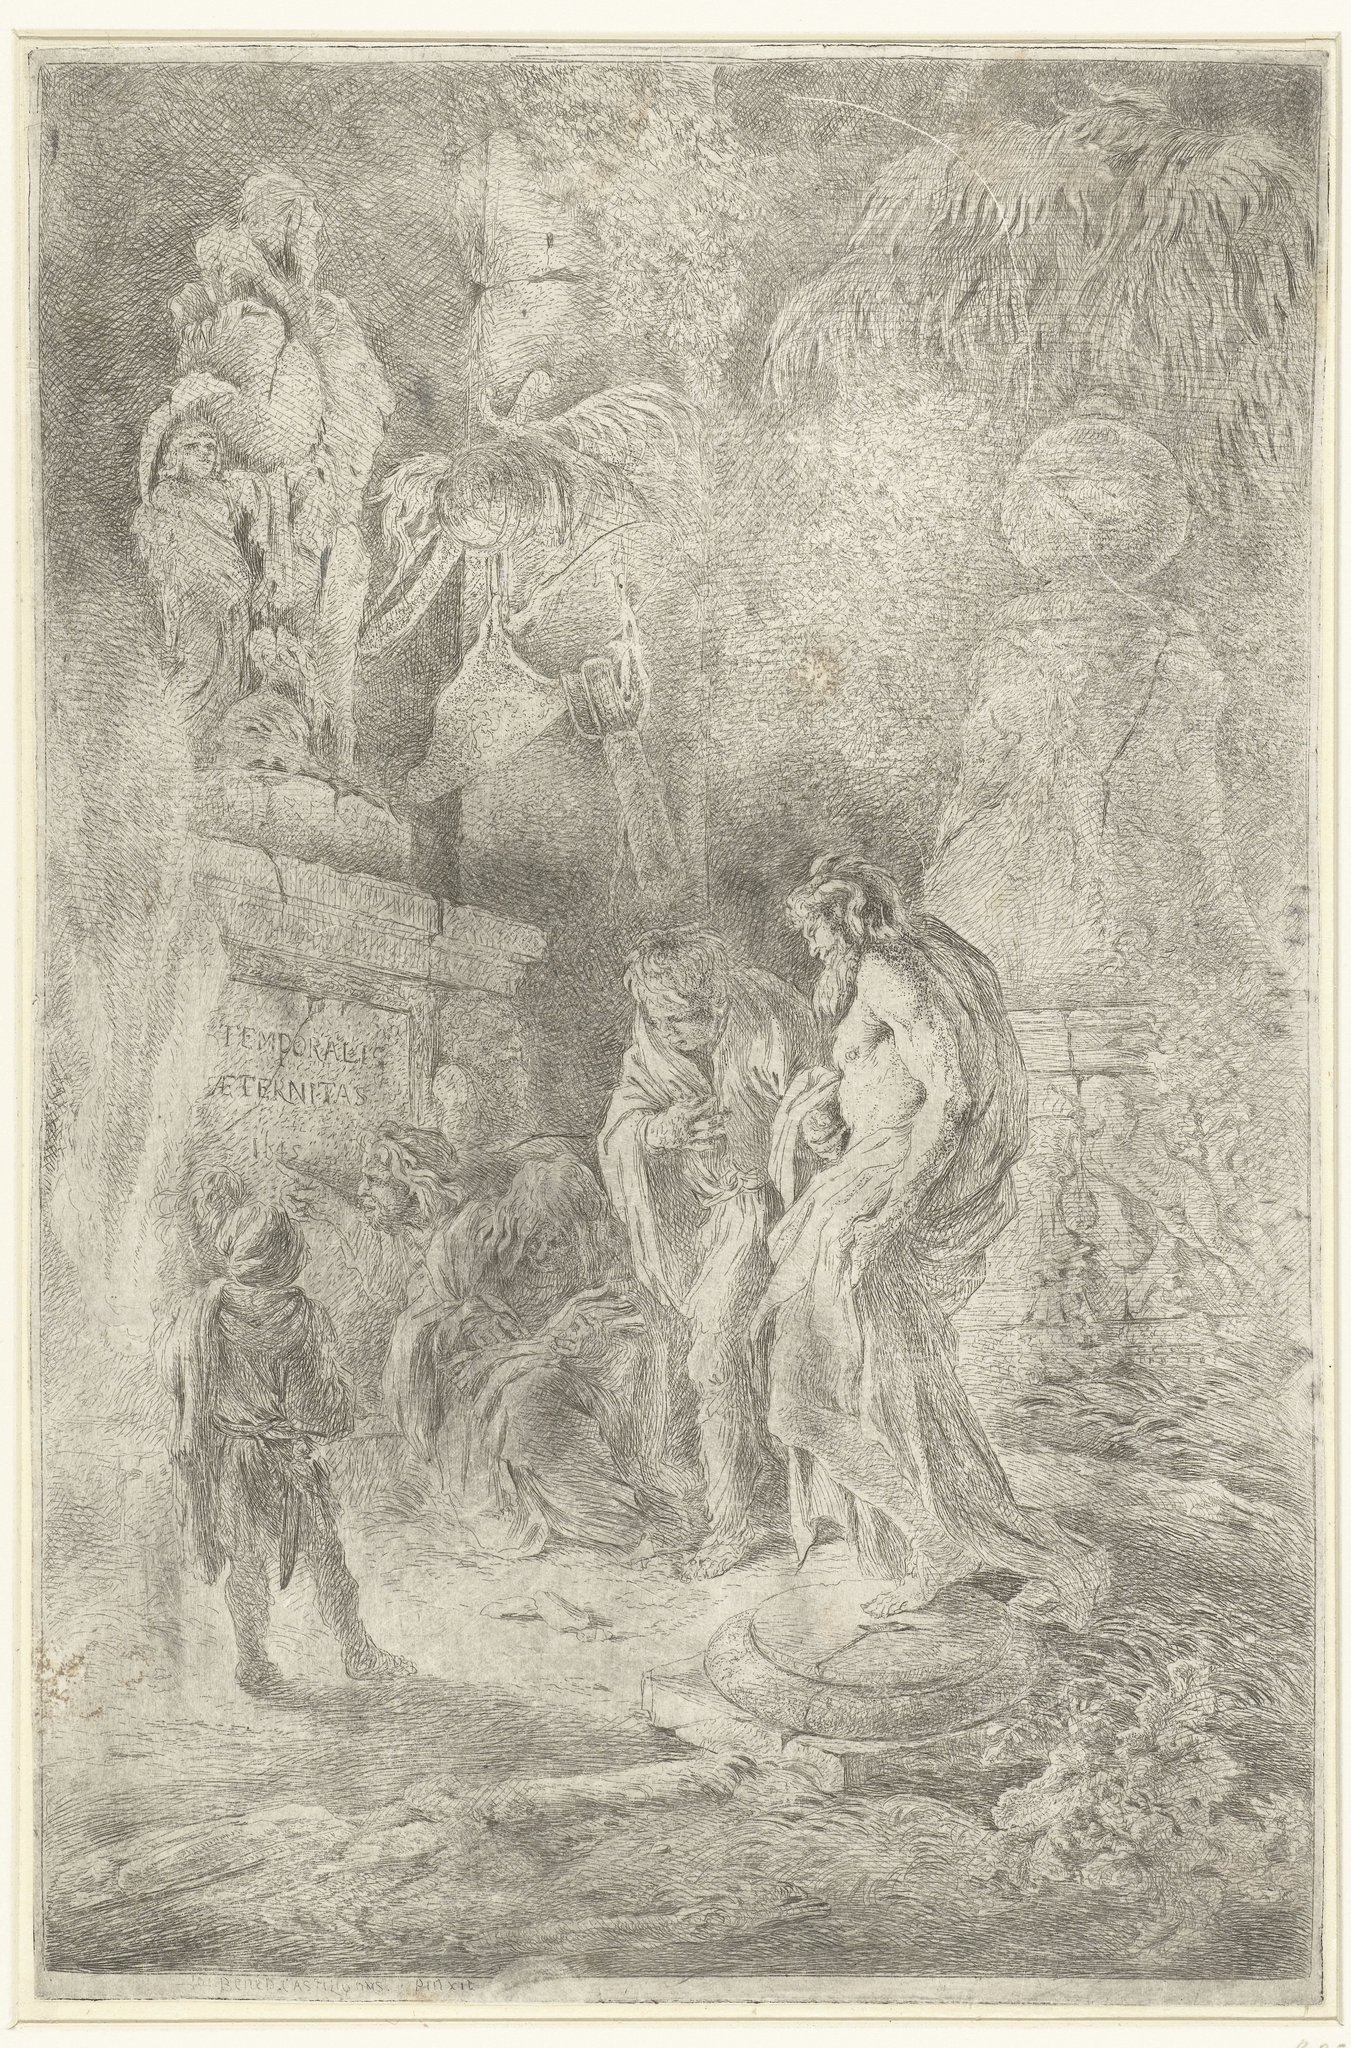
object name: print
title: Temporalis Aeternitas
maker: giovanni benedetto castiglione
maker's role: draughtsman, print maker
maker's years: 1610-1665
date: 1645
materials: paper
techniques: etching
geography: rome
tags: eternity, 'aeternitas'; 'eternità','eternità o perpetuità' (ripa), grave, tomb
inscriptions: collector's mark: Lugt 240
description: Vier mannen bij een grafmonument. Eén leest de tekst op het graf, een tweede schrijft het op. Een jongetje, op de rug gezien, verlicht het geheel met een fakkel.